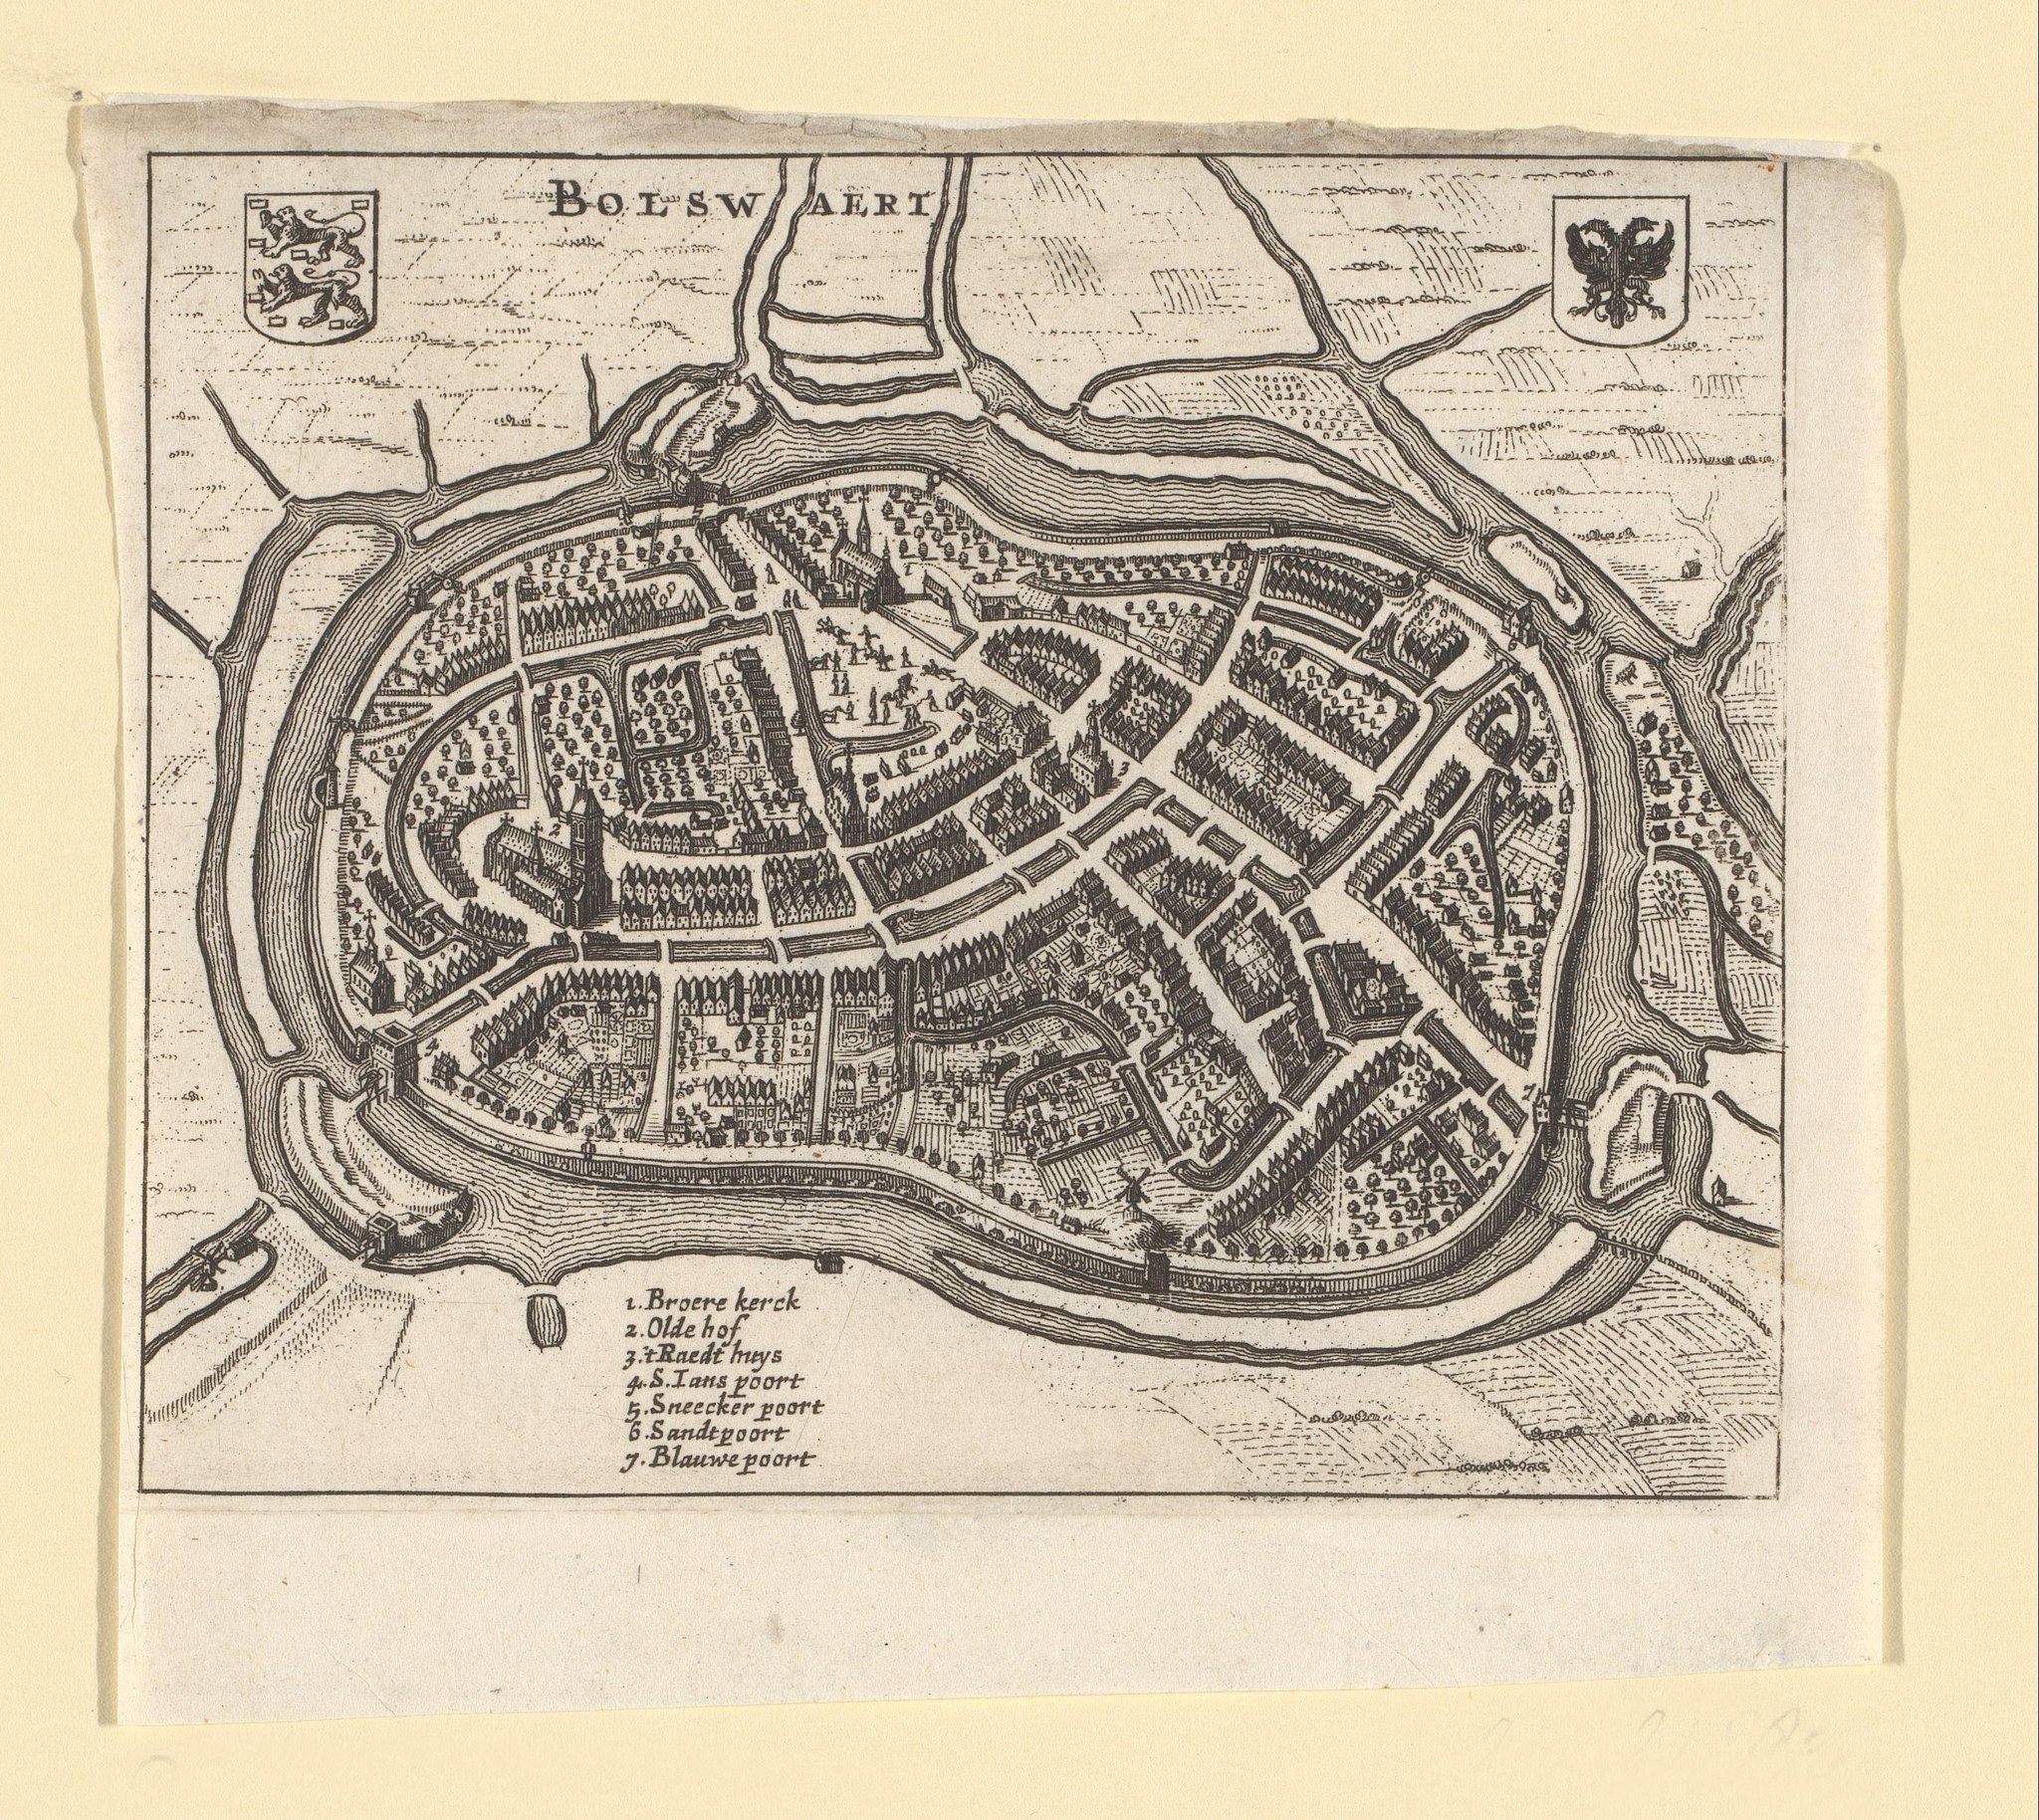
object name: area plan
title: Bolswaert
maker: Anonymous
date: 1660-1662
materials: paper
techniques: engraving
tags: maps of cities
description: Plattegrond van Bolsward, met de bebouwing in opstand. Linksboven het provinciewapen, rechtsboven het stadswapen. Onder een numerieke legenda.